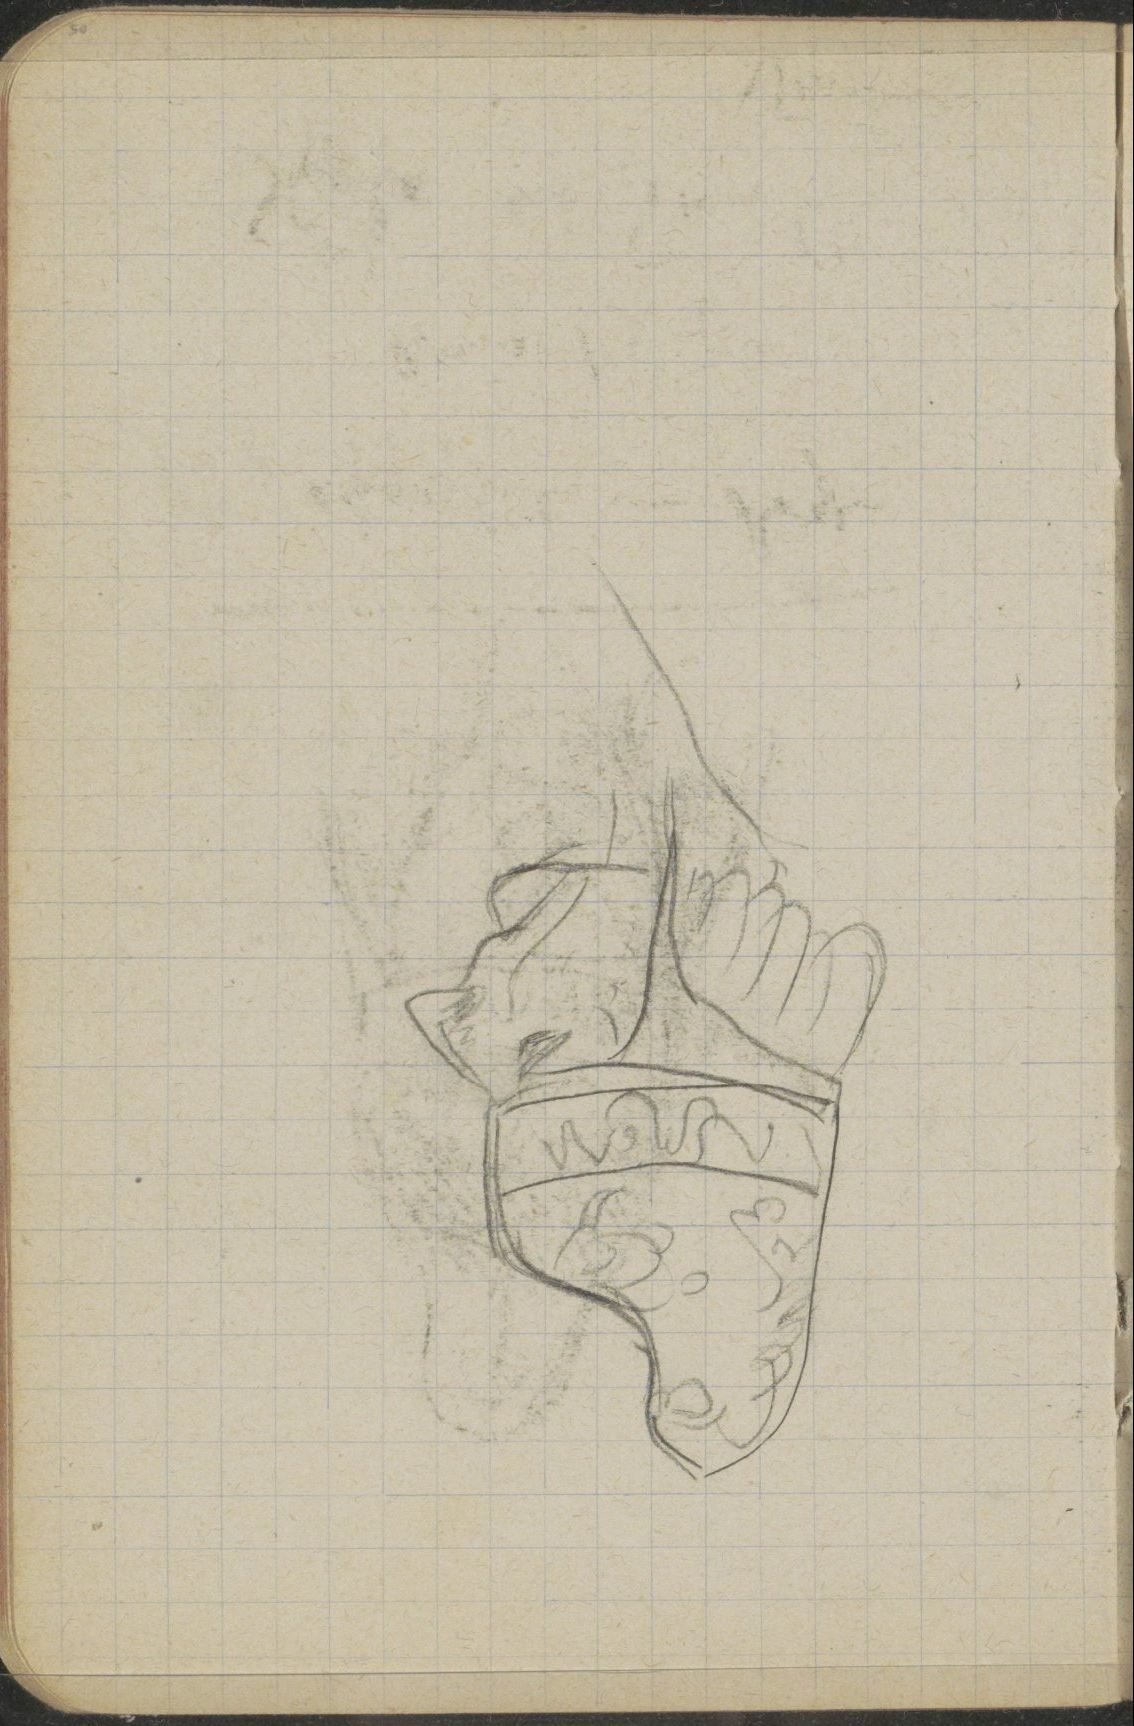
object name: sketchbook leaf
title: Zijaanzicht van het dodenmasker van doge Alvise Giovanni Mocenigo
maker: marius bauer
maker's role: draughtsman, print maker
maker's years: 1867-1932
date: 1895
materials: chalk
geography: venice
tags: death-mask, other sovereign: doge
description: Pagina 50 uit een schetsboek met 28 bladen.